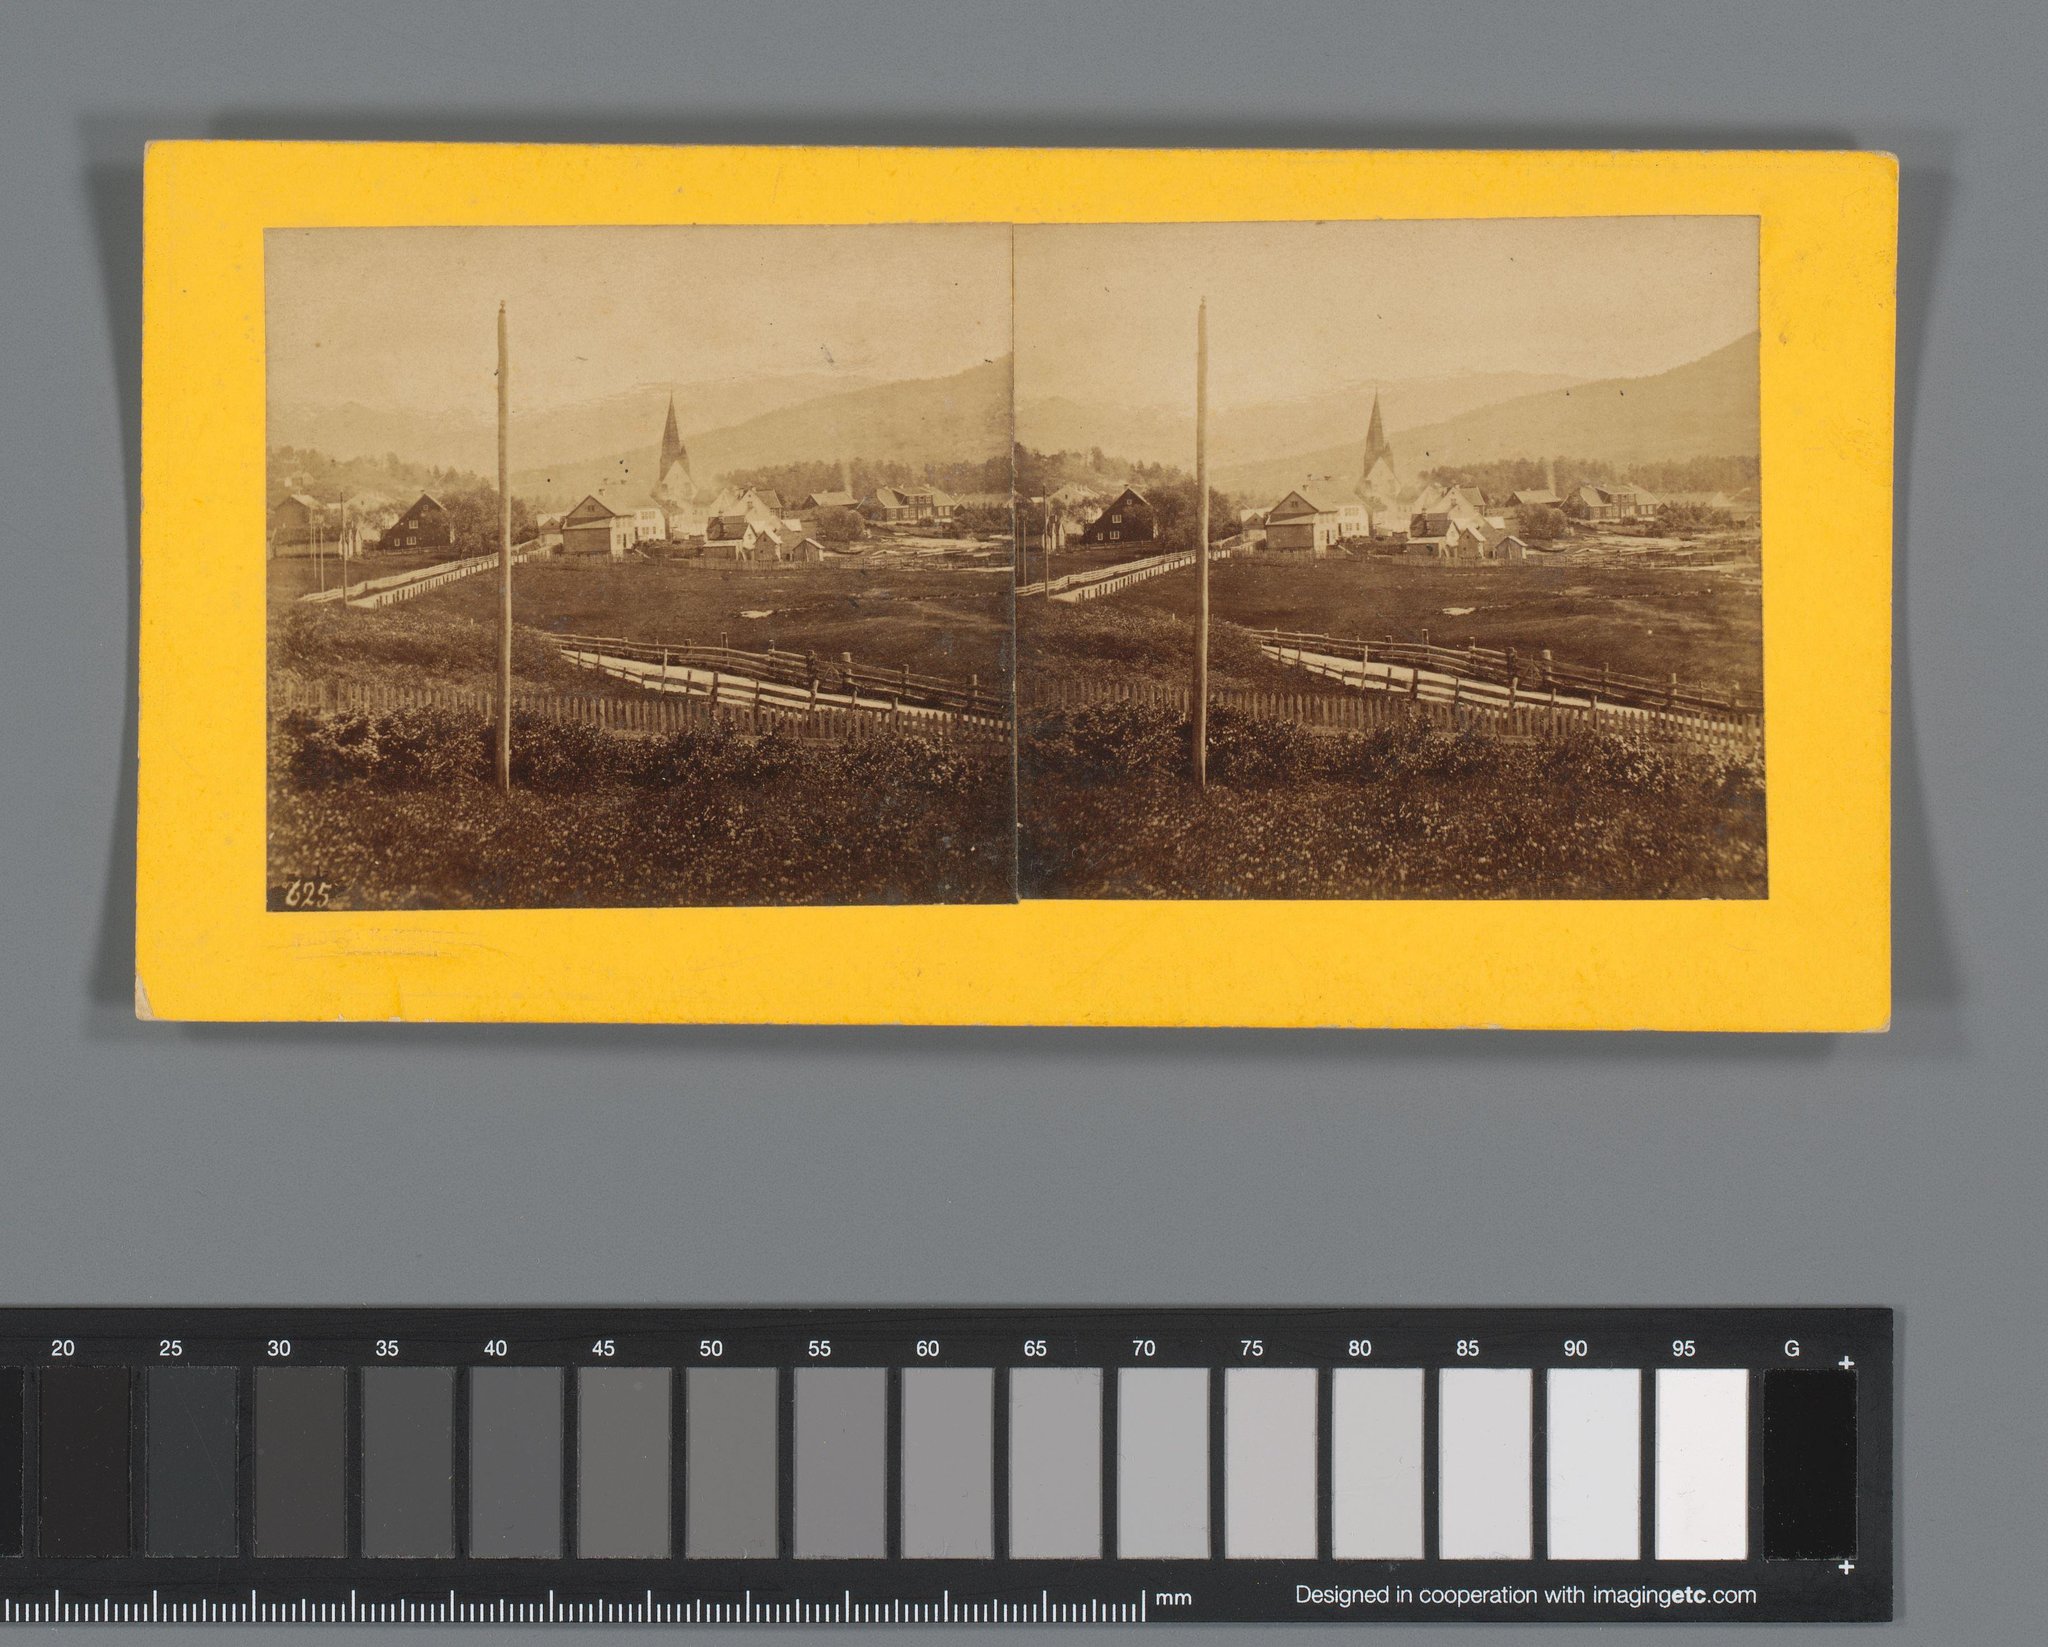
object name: stereograph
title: Norge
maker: knud knudsen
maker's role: fotograaf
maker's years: 1832-1915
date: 1861-1870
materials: cardboard, paper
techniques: albumen print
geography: voss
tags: city-view, and landscape with man-made constructions, village